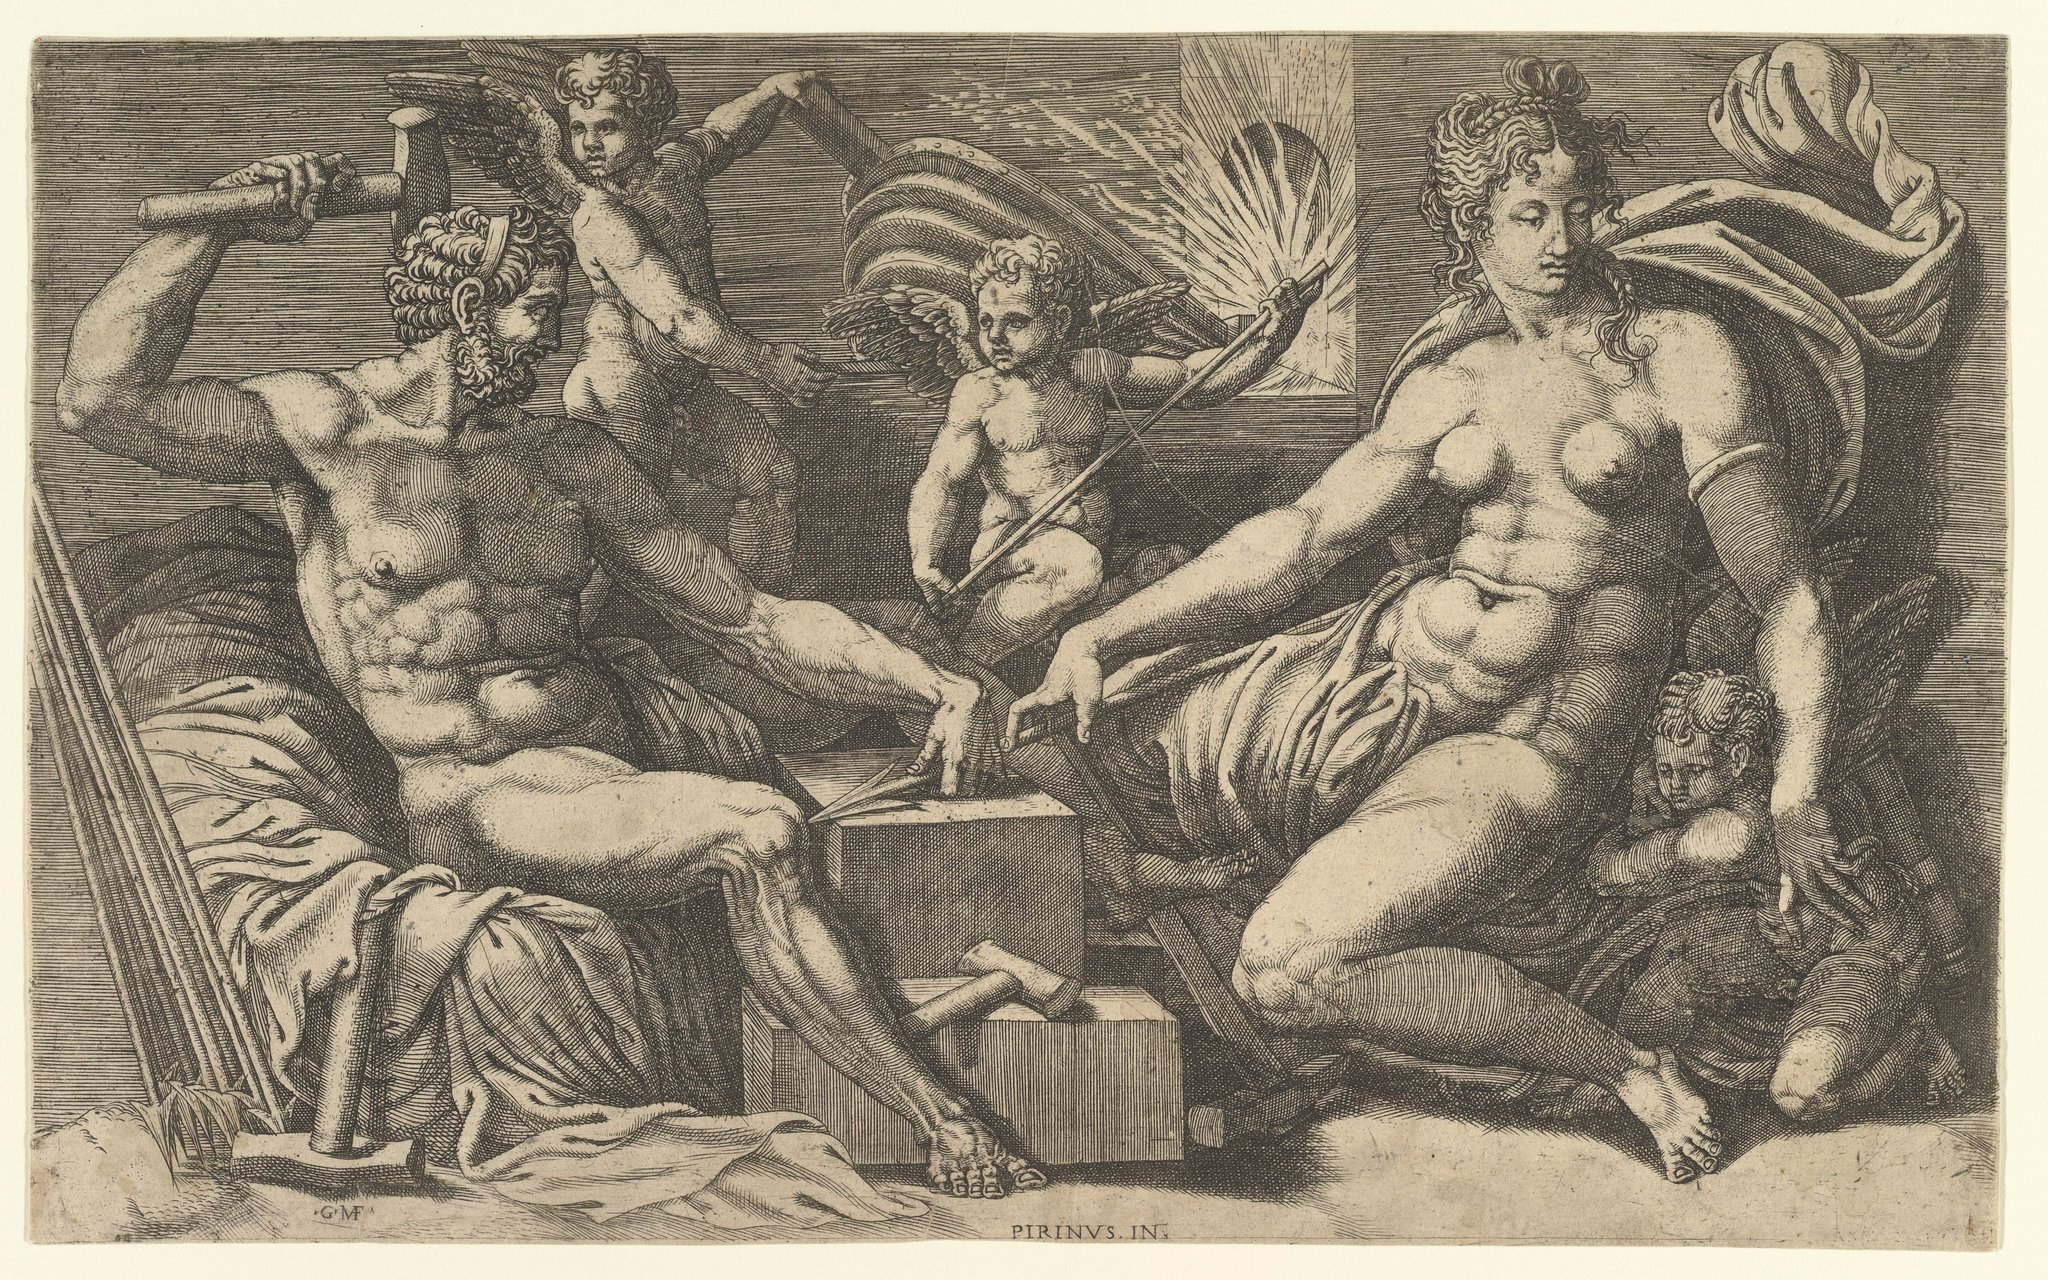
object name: print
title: Venus and Vulcan at the Forge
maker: giorgio ghisi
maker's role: artist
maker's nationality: italian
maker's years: 1515-1582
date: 1555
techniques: engraving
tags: venus,vulcan